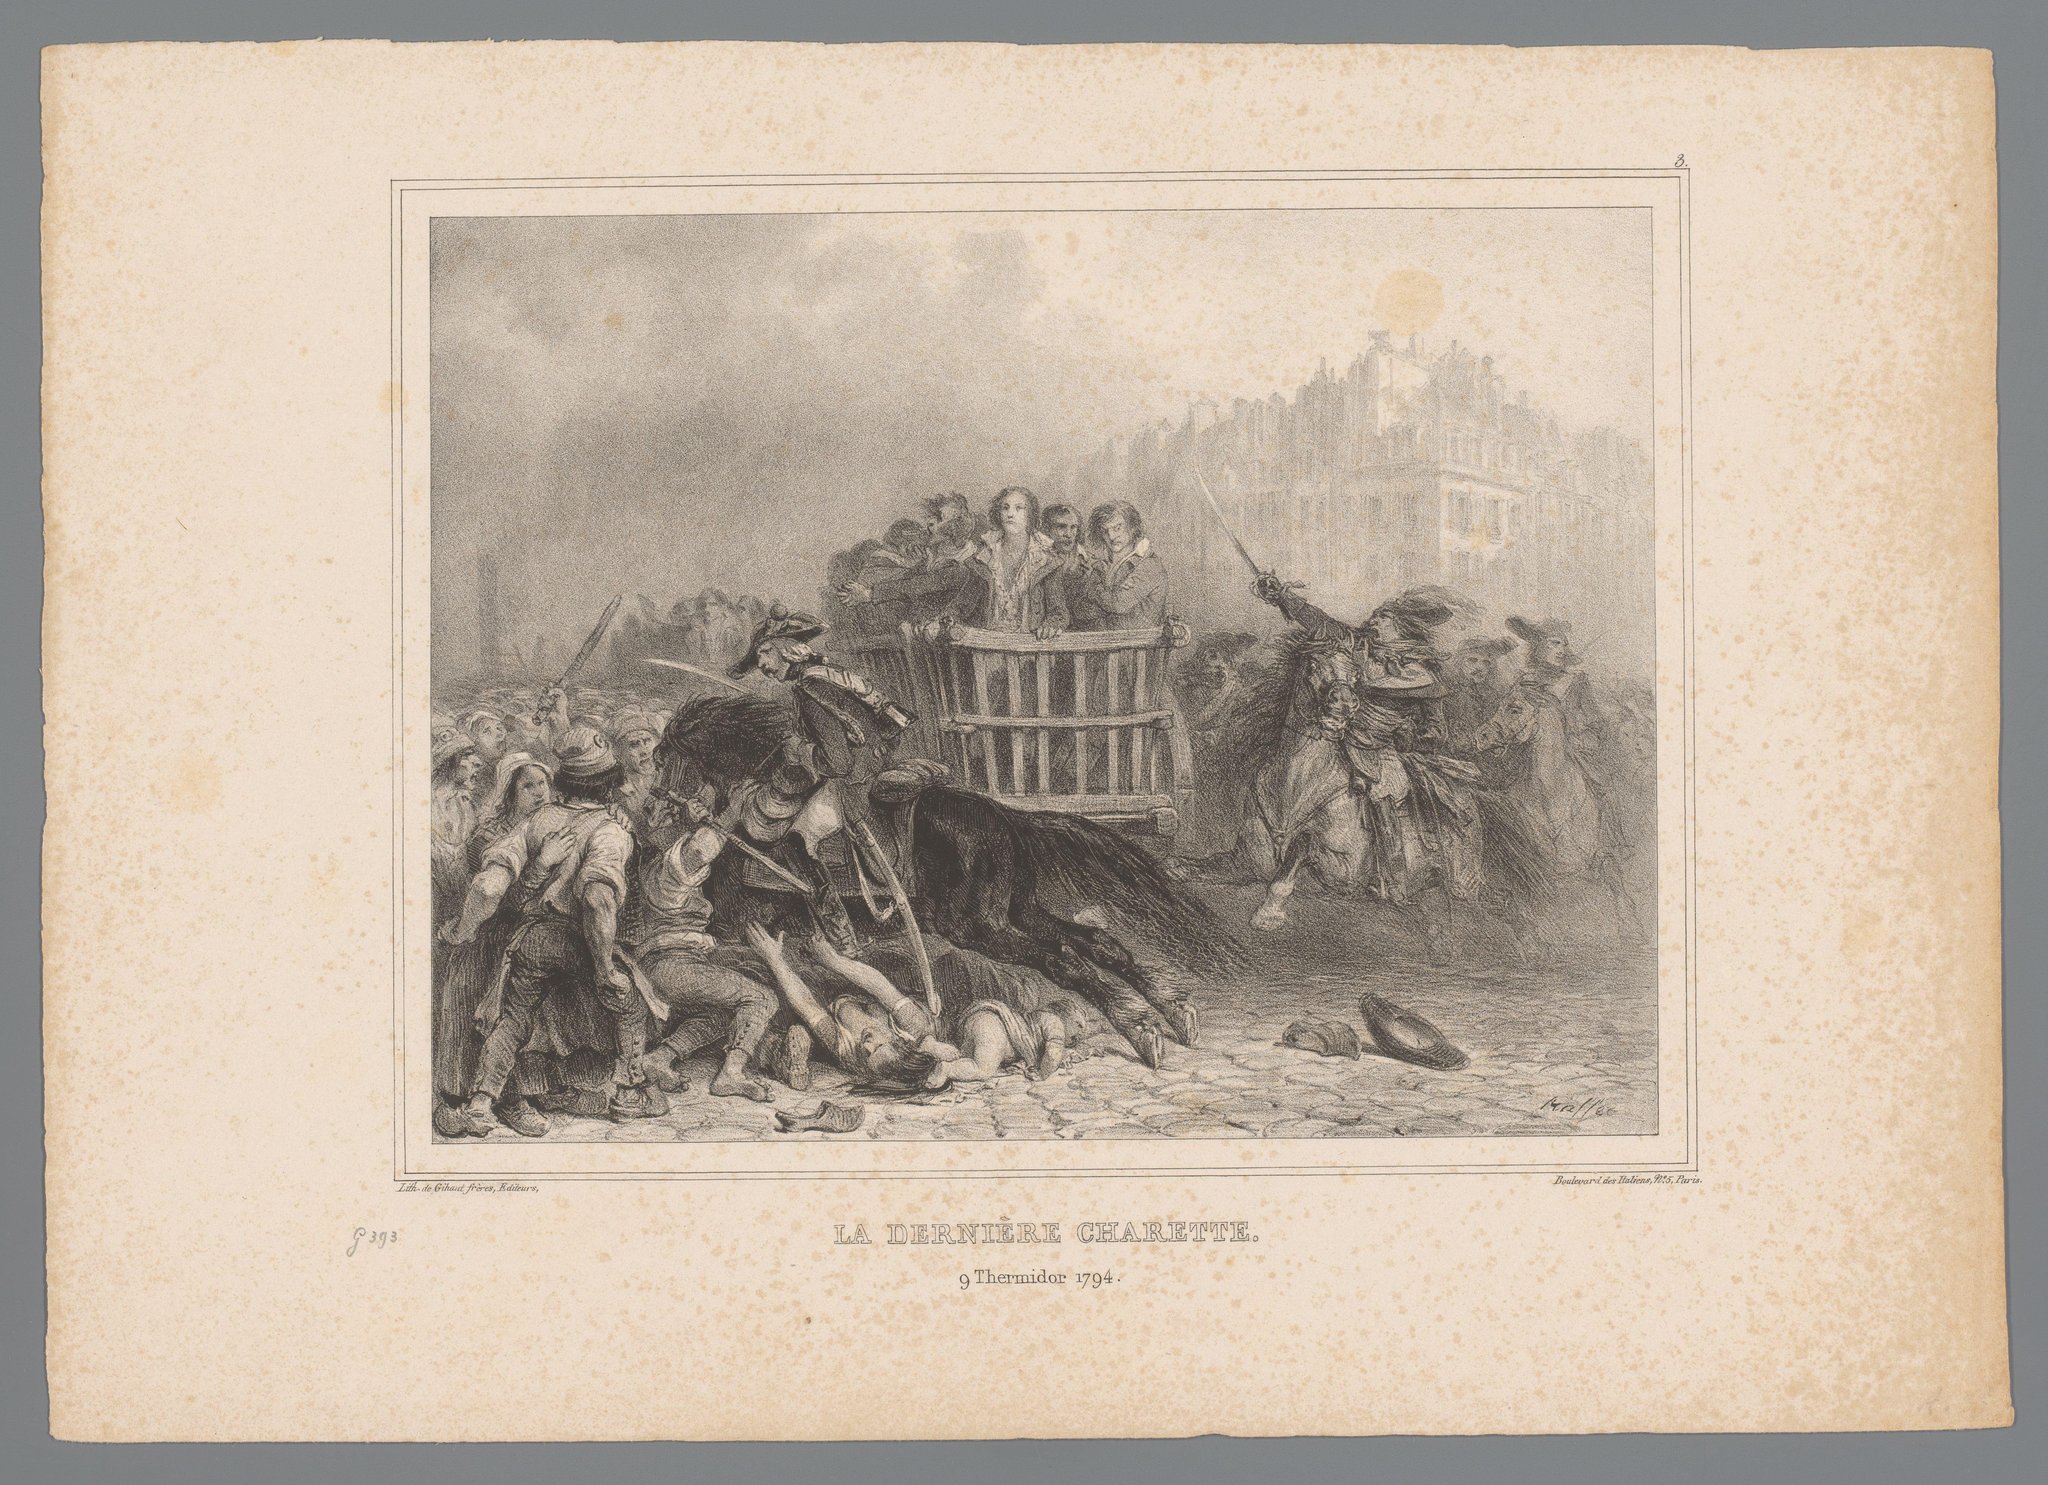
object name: print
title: Album met twaalf prenten van Auguste Raffet uit 1835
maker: denis auguste marie raffet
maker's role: draughtsman, print maker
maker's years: 1804-1860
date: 1835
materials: paper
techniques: lithograph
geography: paris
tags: riding a horse, ass, or mule; rider, horseman, ancient forms of military vehicles: chariot, battle wagon, etc., hacking and thrusting weapons: sword, paris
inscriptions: collector's mark: Lugt 964